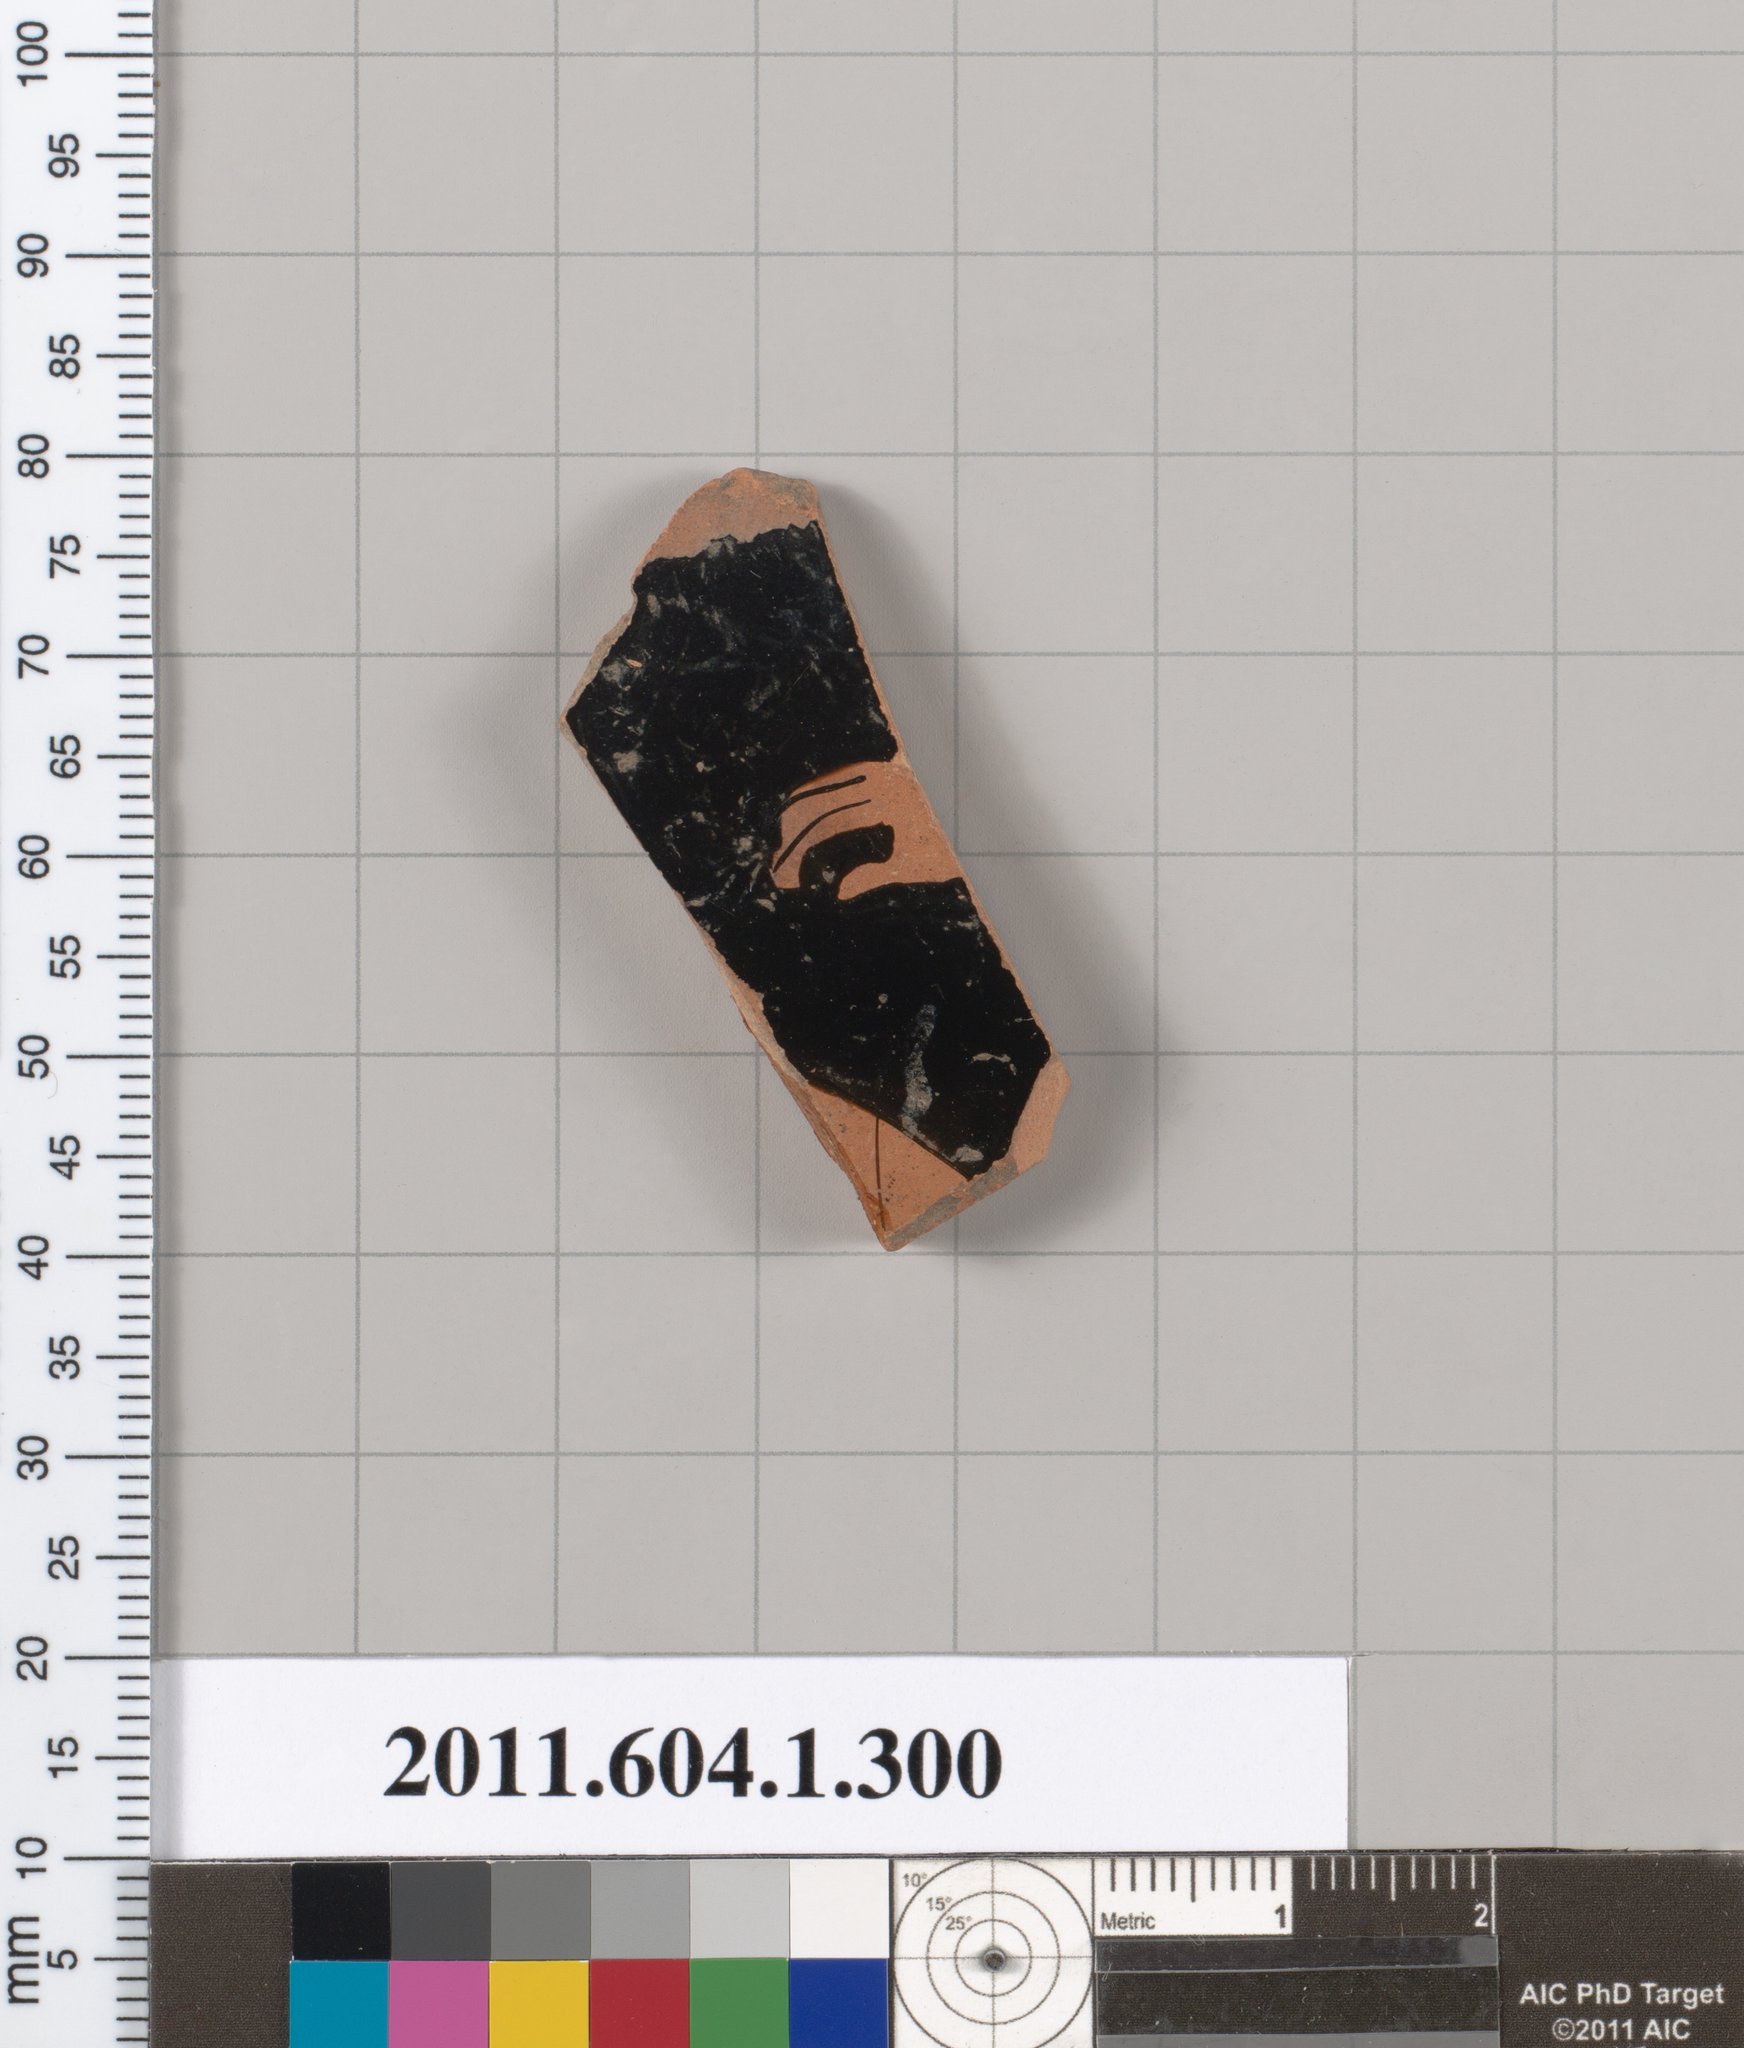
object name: kylix fragment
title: Terracotta fragment of a kylix (drinking cup)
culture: greek, attic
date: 475-451 BCE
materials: terracotta